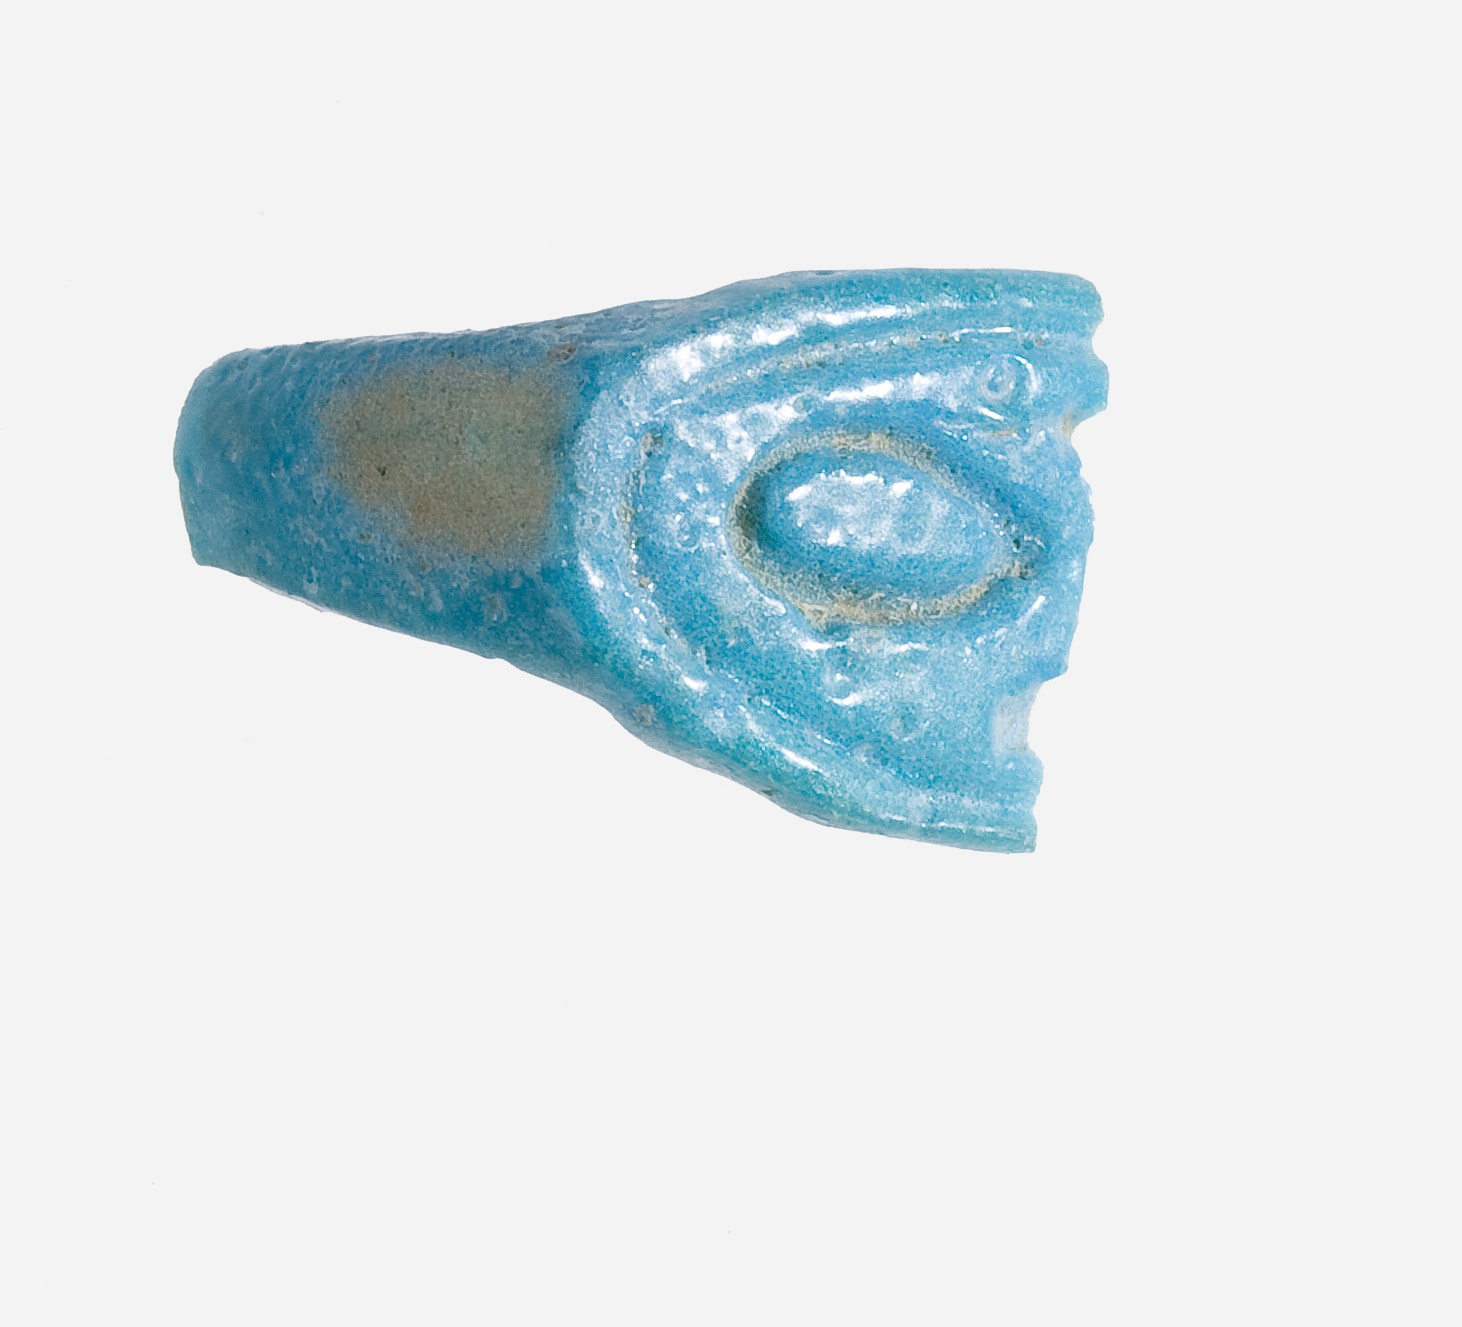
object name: ring fragment, ankh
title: Ring Fragment with ankh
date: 1390-1352 BCE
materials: faience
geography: egypt